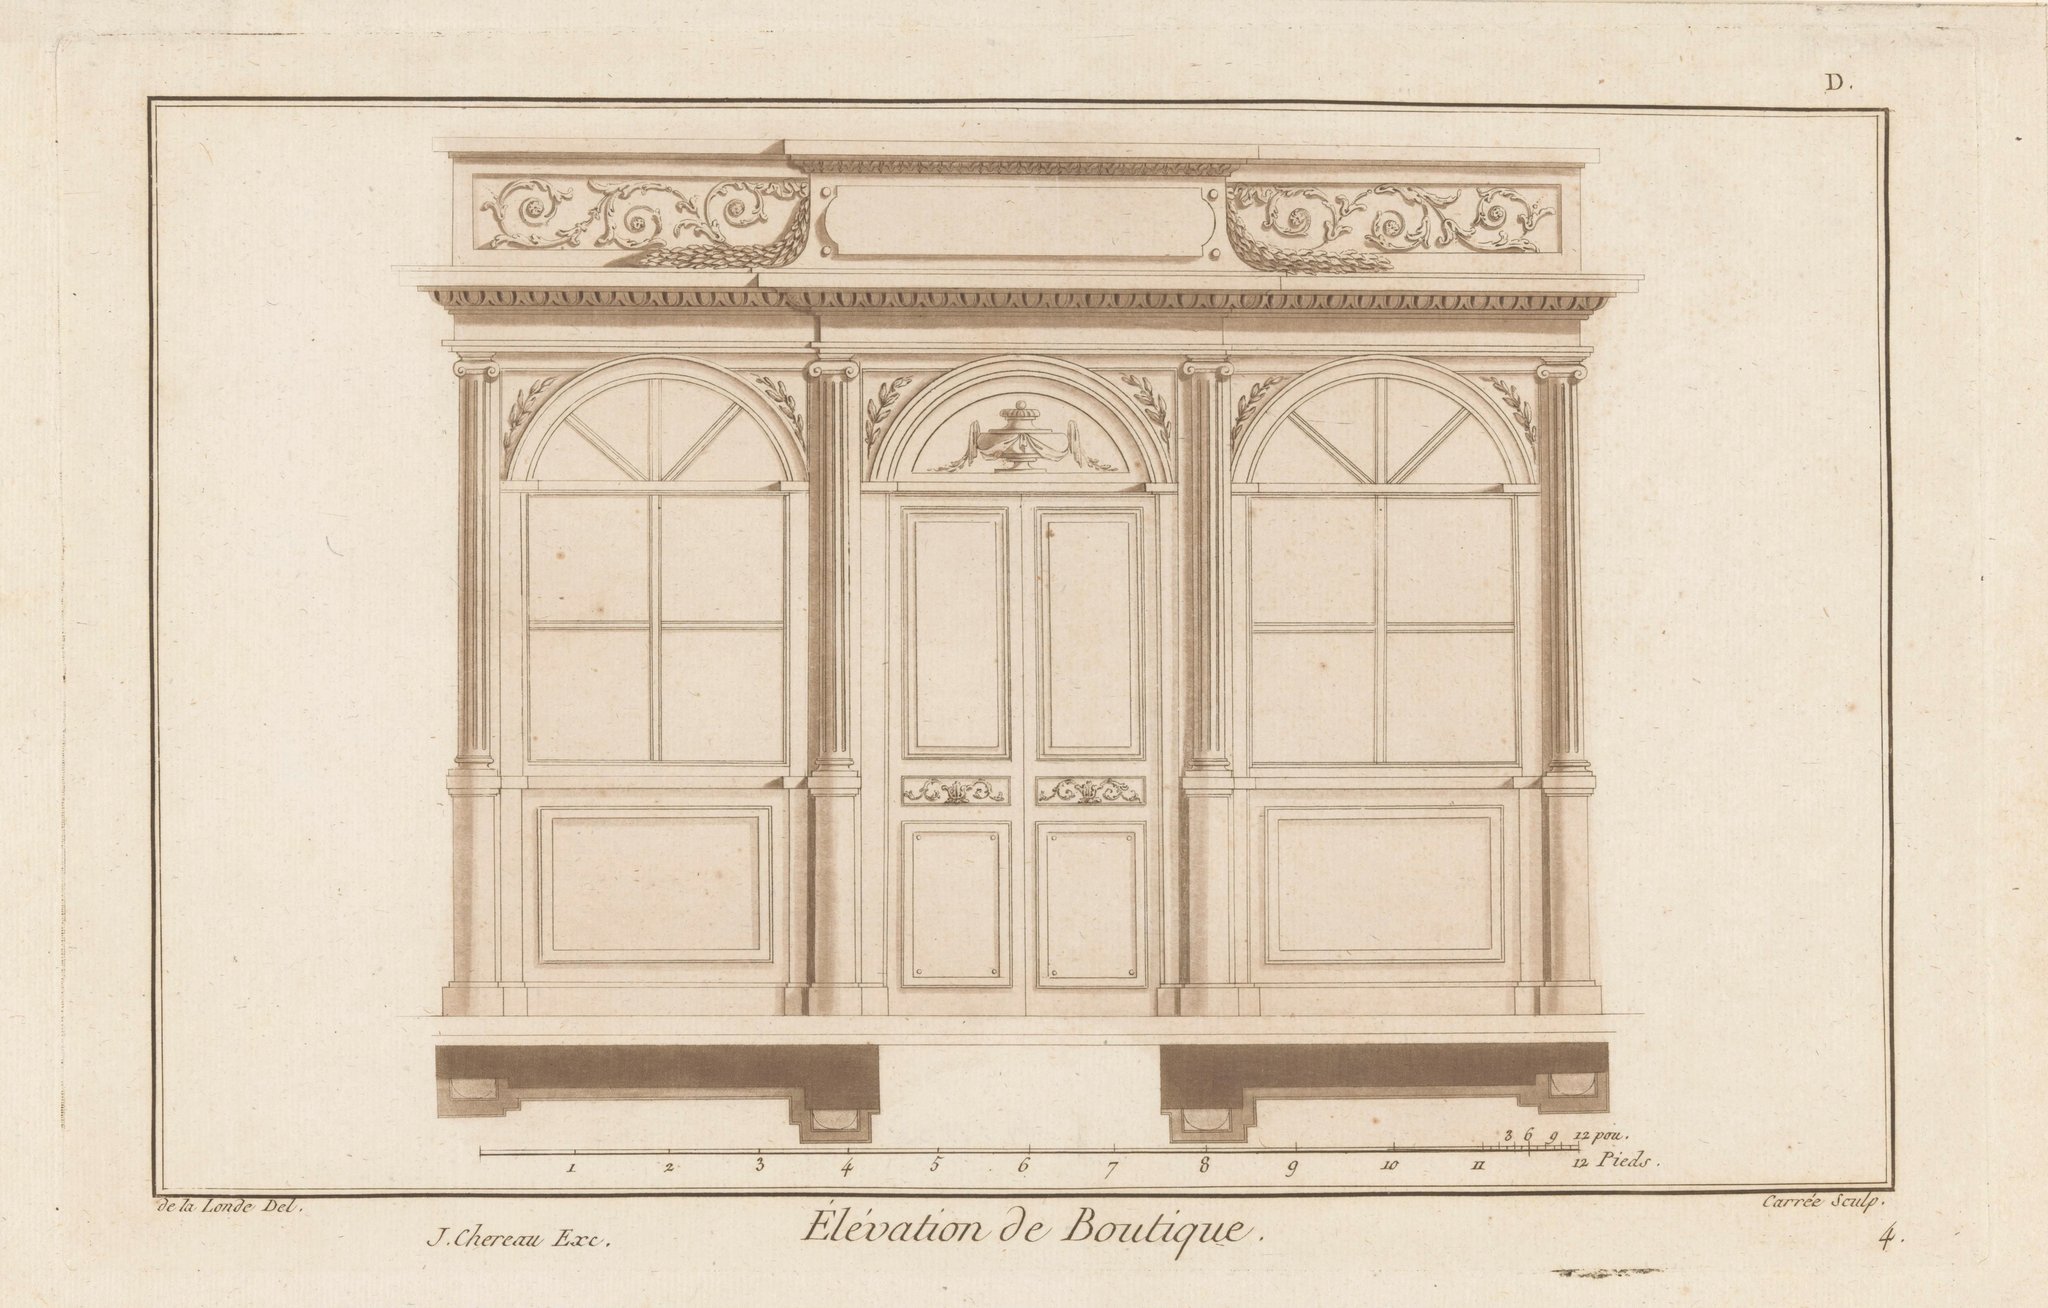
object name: ornament print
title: Façade met zuilen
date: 1788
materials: paper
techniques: aquatint, etching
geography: paris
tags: column, pillar ~ architecture, façade (of house or building)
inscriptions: collector's mark: Lugt 2760, collector's mark: Lugt 2228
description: Een façade met in het midden twee deuren met een halfrond dessus-de-porte met een vaas. Aan weerszijden halfronde ramen geflankeerd door zuilen. Aan de bovenzijden panelen met vlechtwerk.